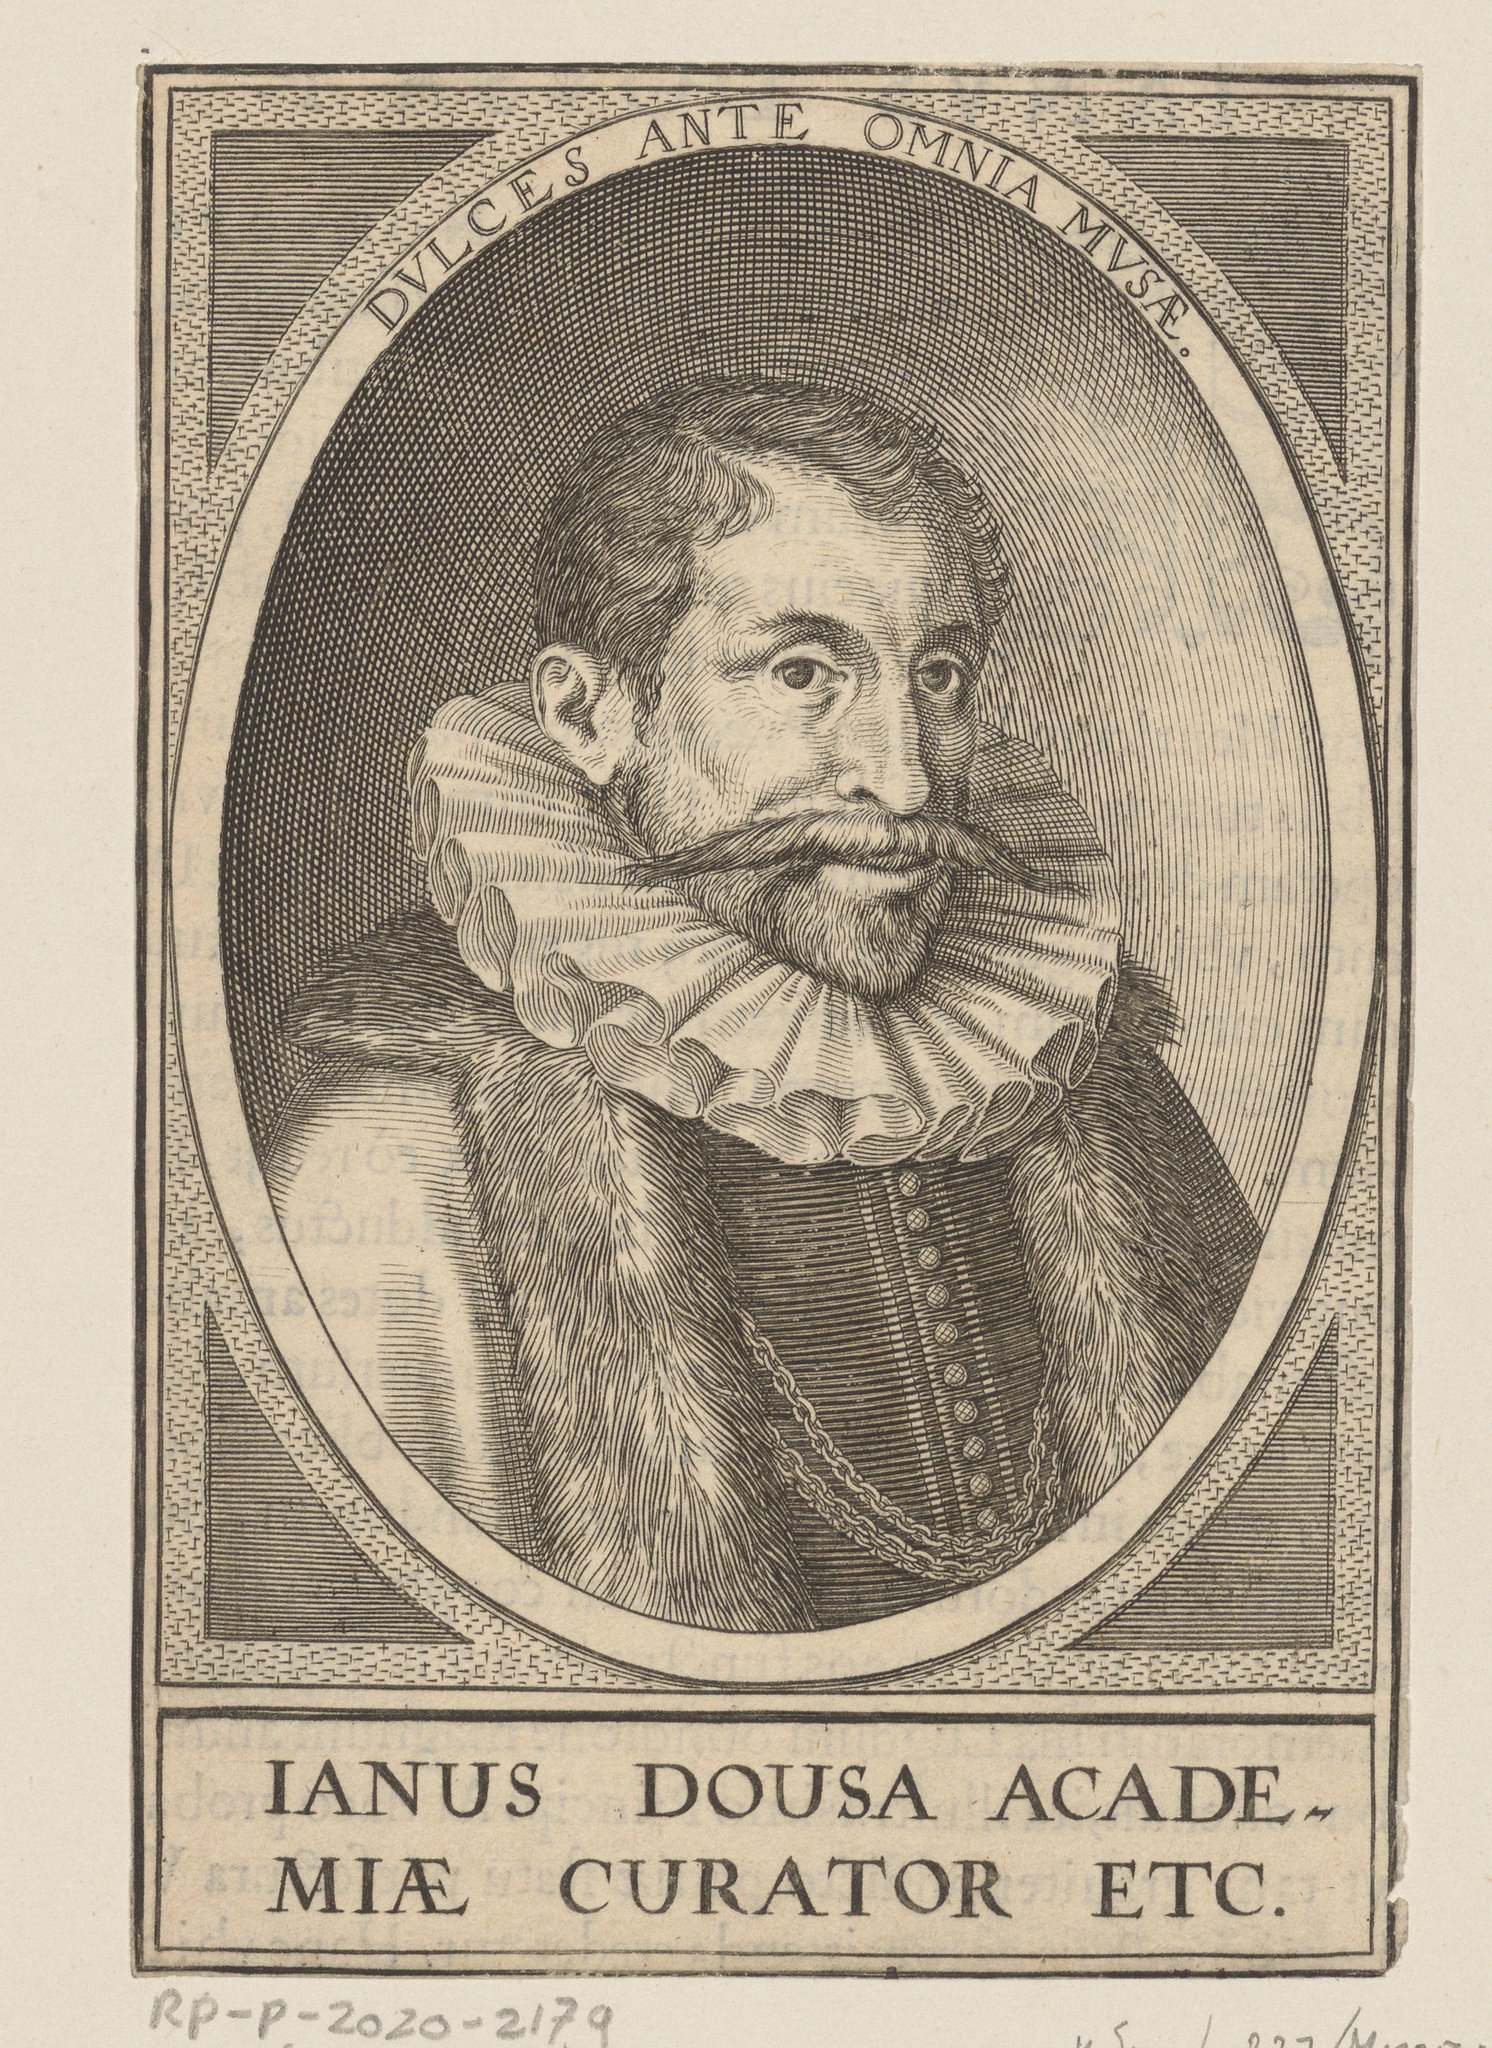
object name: book illustration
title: Portret van Jan van der Does, heer van Noordwijk en Kattendijke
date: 1617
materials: paper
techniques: engraving, letterpress printing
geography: leiden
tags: commander-in-chief, general, marshal, historical persons, writer, poet, author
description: Prent uit: Meursius, Joannes. Icones, elogia ac vitae professorum Lugdunensium apud Batavos (...). Leiden: Andries Clouck, 1617. Prent mogelijk ook gebruikt in eerdere en latere edities.